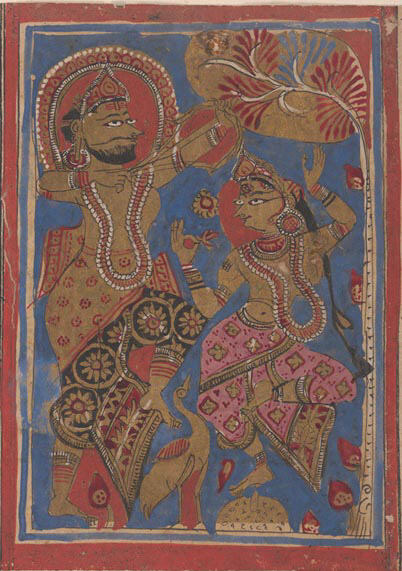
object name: folio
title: The Courtesan Kosa with the King's Charioteer: Folio from a Kalpasutra Manuscript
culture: indian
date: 1401-1500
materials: gold, ink, paper, watercolor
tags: men,women